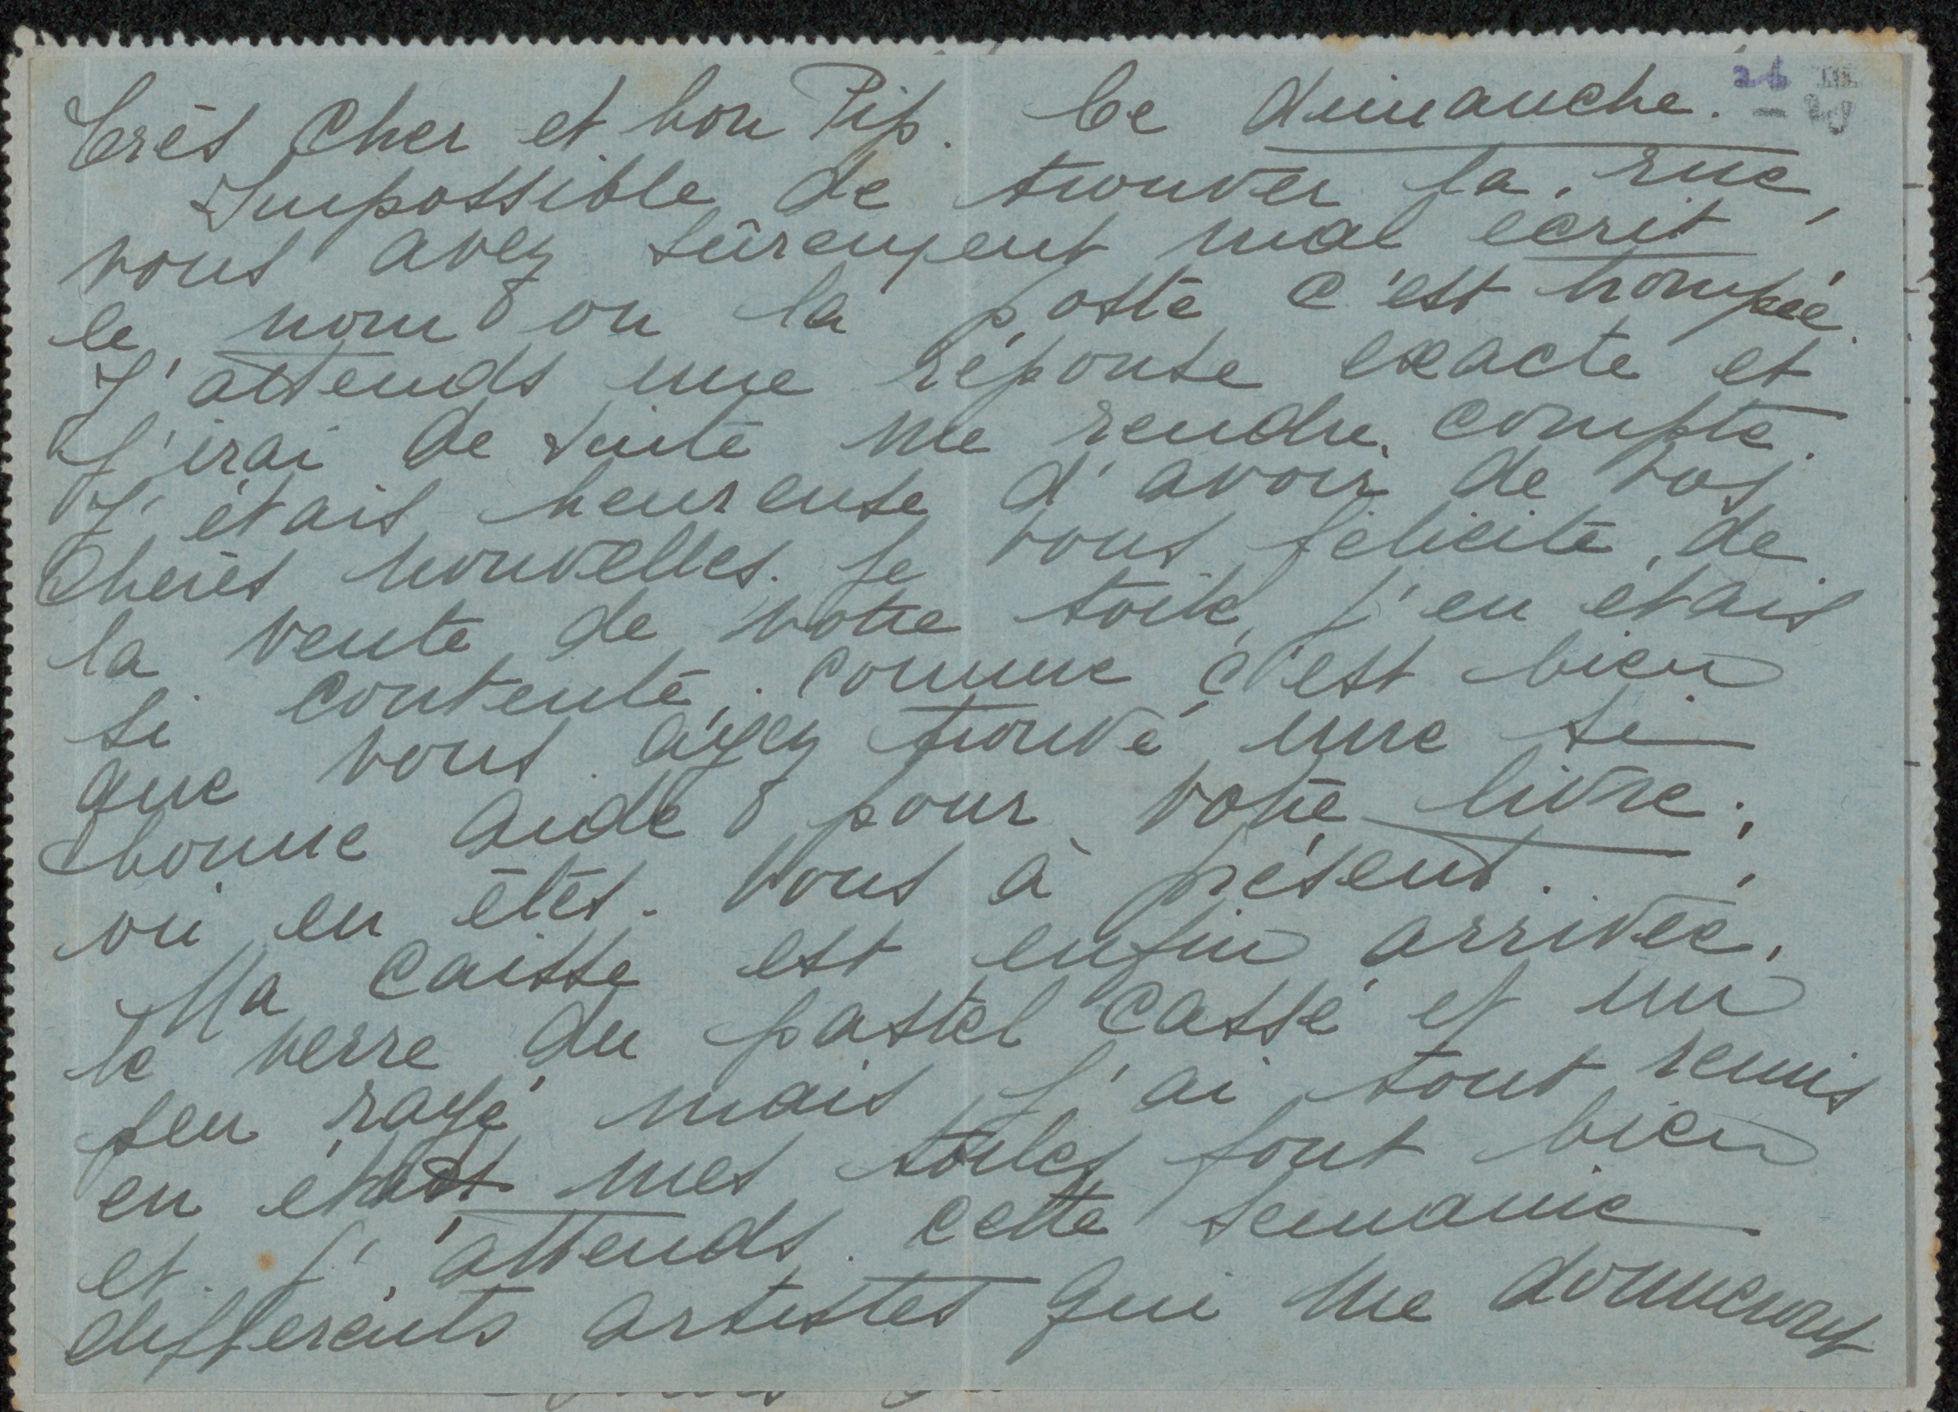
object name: letter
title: Brief aan Philip Zilcken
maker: rose imel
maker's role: draughtsman, painter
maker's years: 1901-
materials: ink, paper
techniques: pen, writing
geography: paris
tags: the hague, philip zilcken, painting (including book-illumination, miniature-painting), printed matter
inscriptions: collector's mark: ‘RPK’